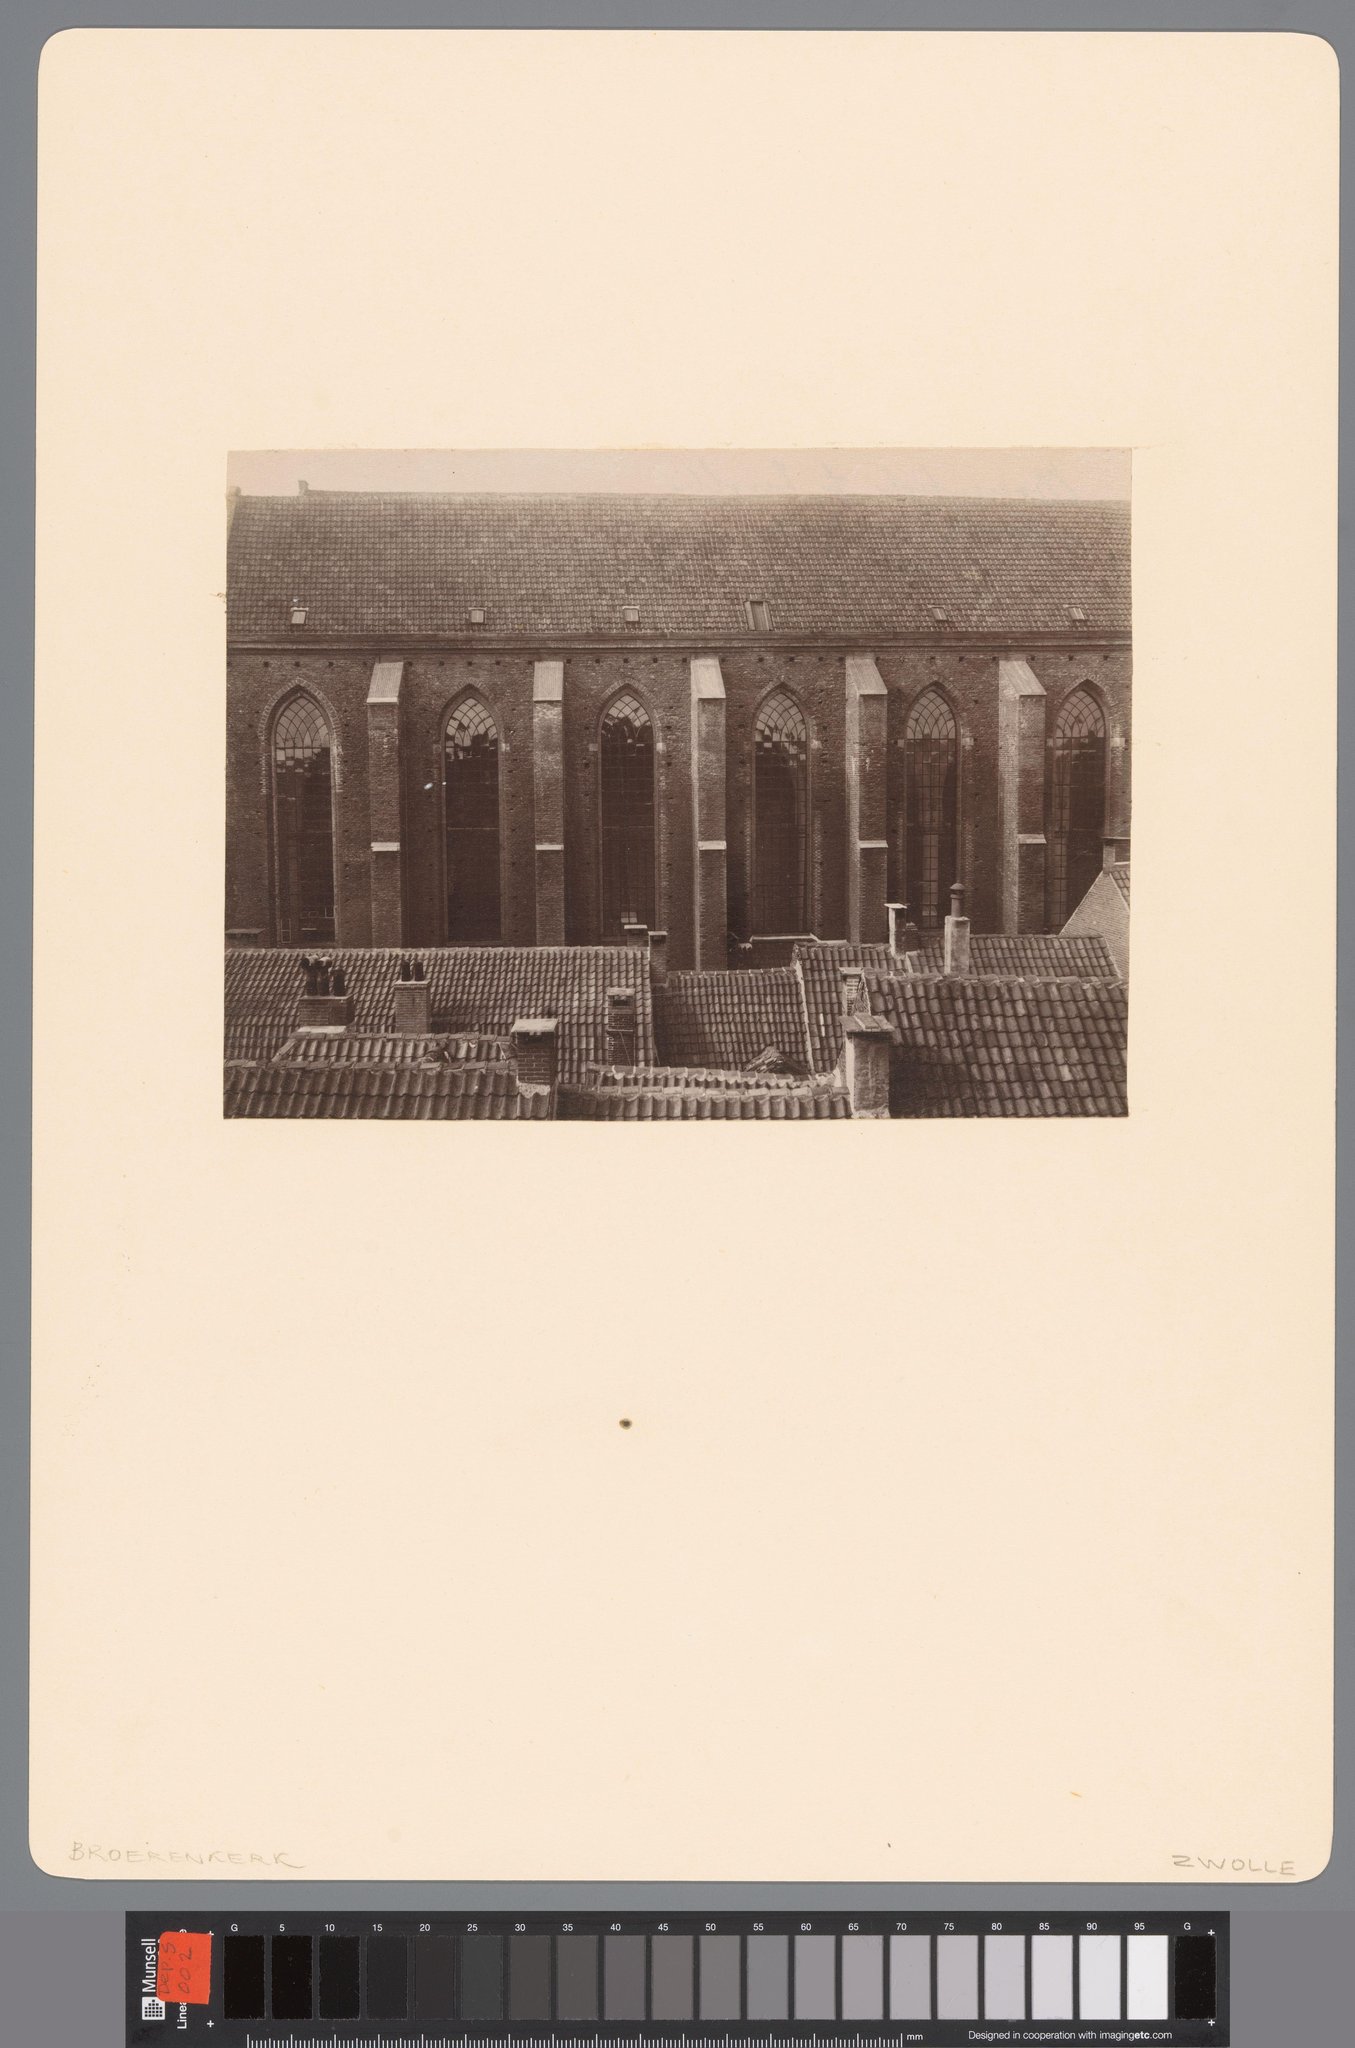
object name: photograph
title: Zuidzijde van de Broerenkerk te Zwolle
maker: anoniem (monumentenzorg)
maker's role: fotograaf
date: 1909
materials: cardboard, photographic support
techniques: albumen print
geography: zwolle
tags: church (exterior)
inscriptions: annotation: ‘Broerenkerk te Zwolle/ Zuidzijde/ juni 1909’, annotation: ‘Broerenkerk/ Zwolle’